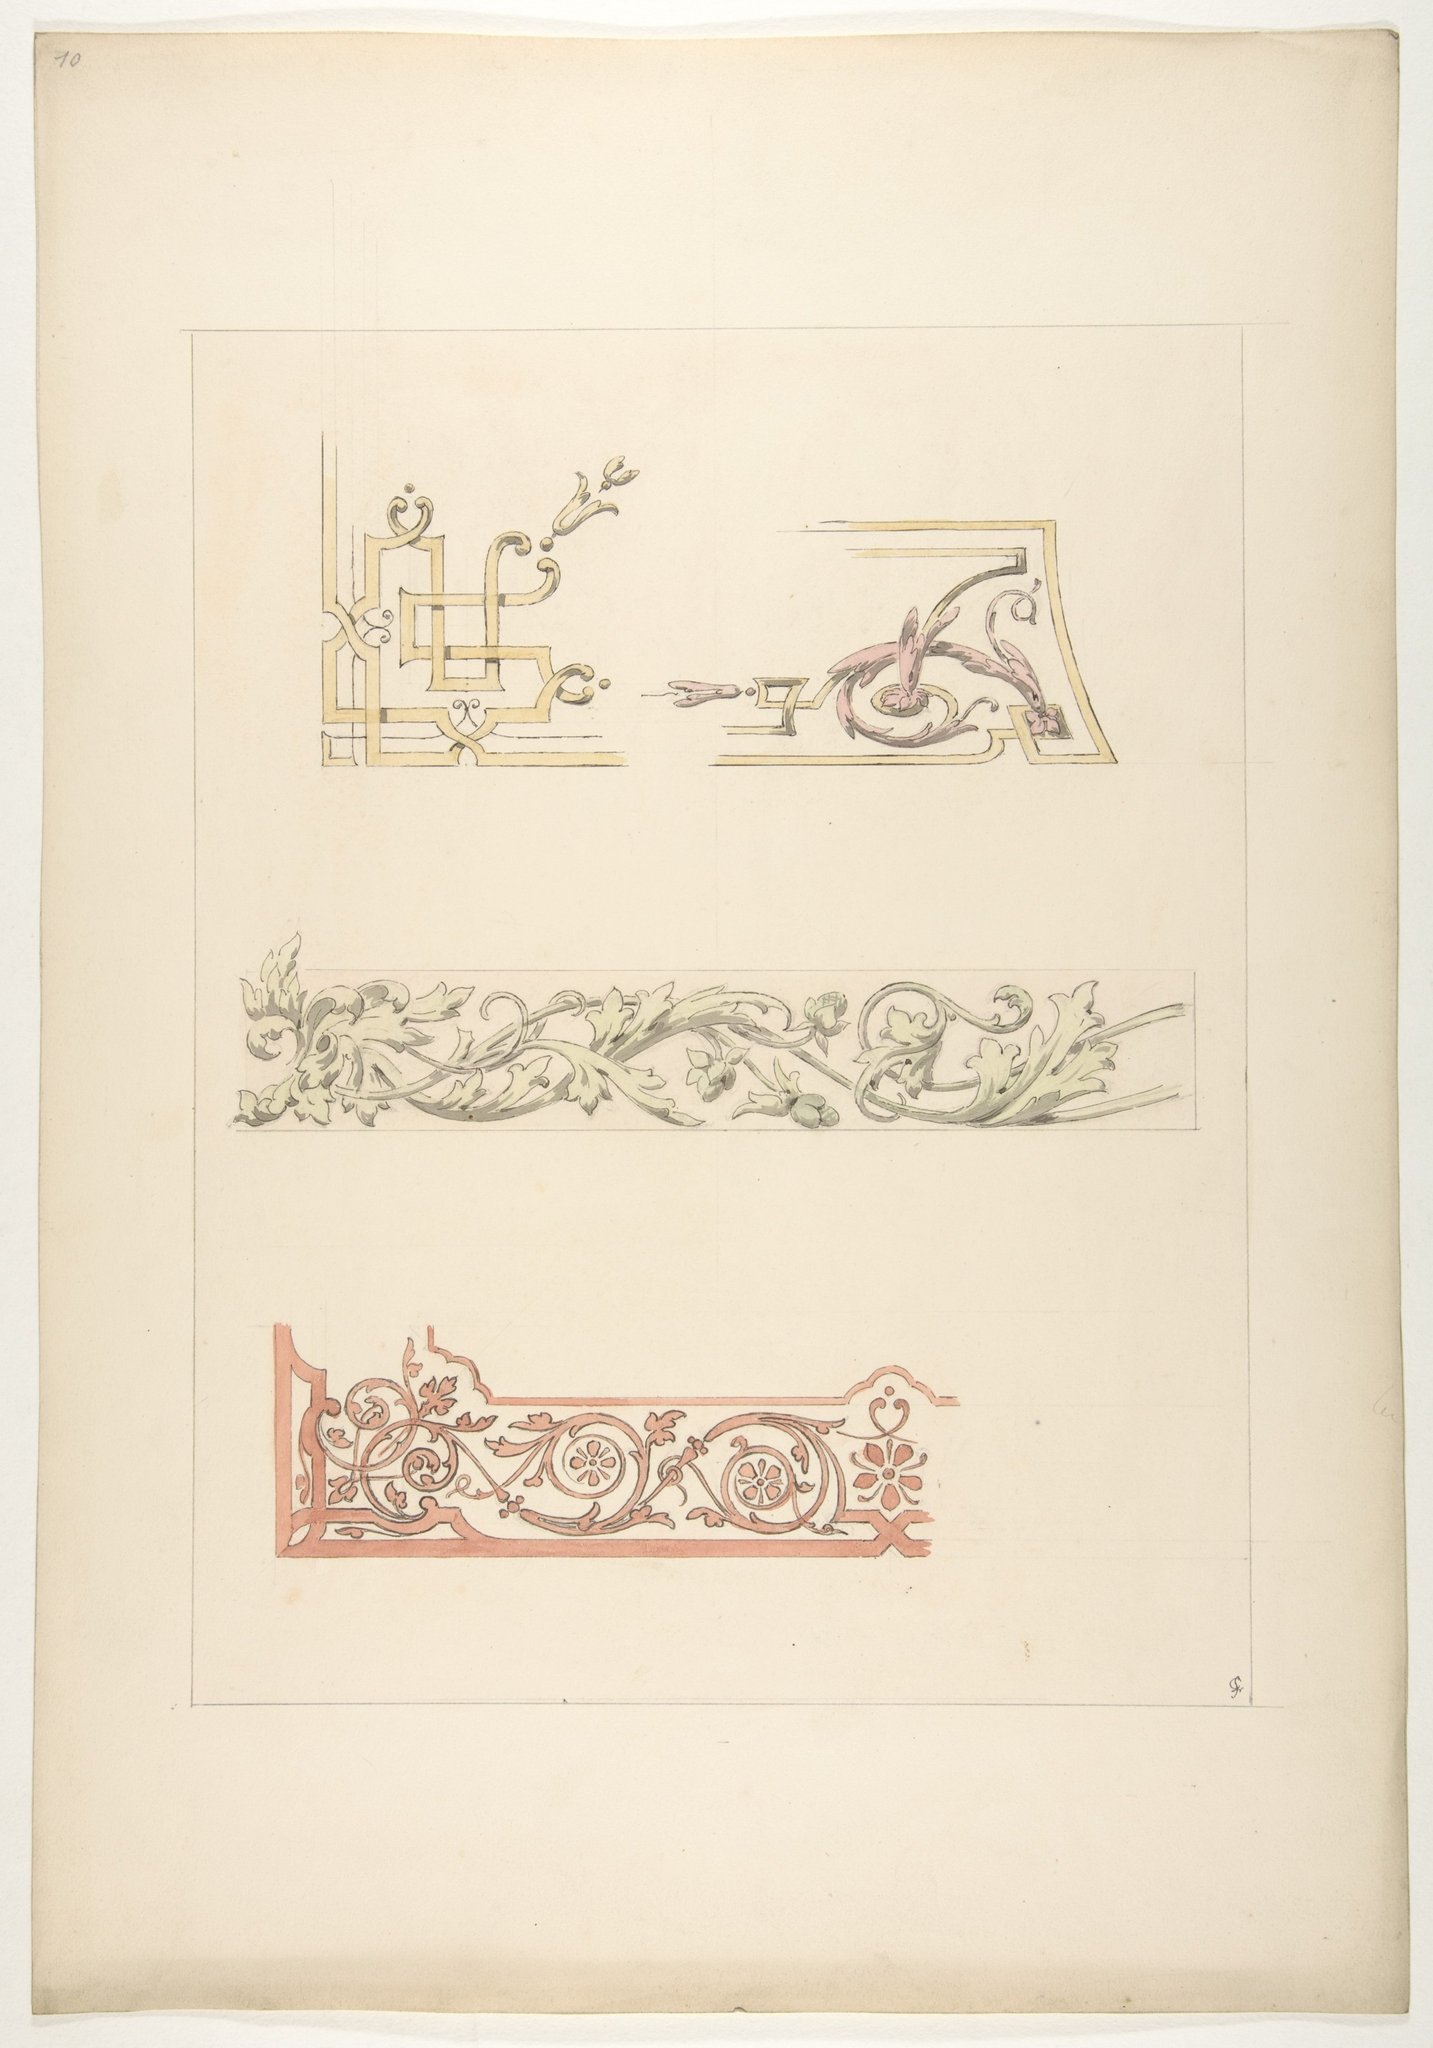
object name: drawing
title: Three designs for decorative borders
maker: jules-edmond-charles lachaise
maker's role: artist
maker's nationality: french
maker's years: 1897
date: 1830-1897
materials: graphite, ink, watercolor, paper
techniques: pen, wash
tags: ornament